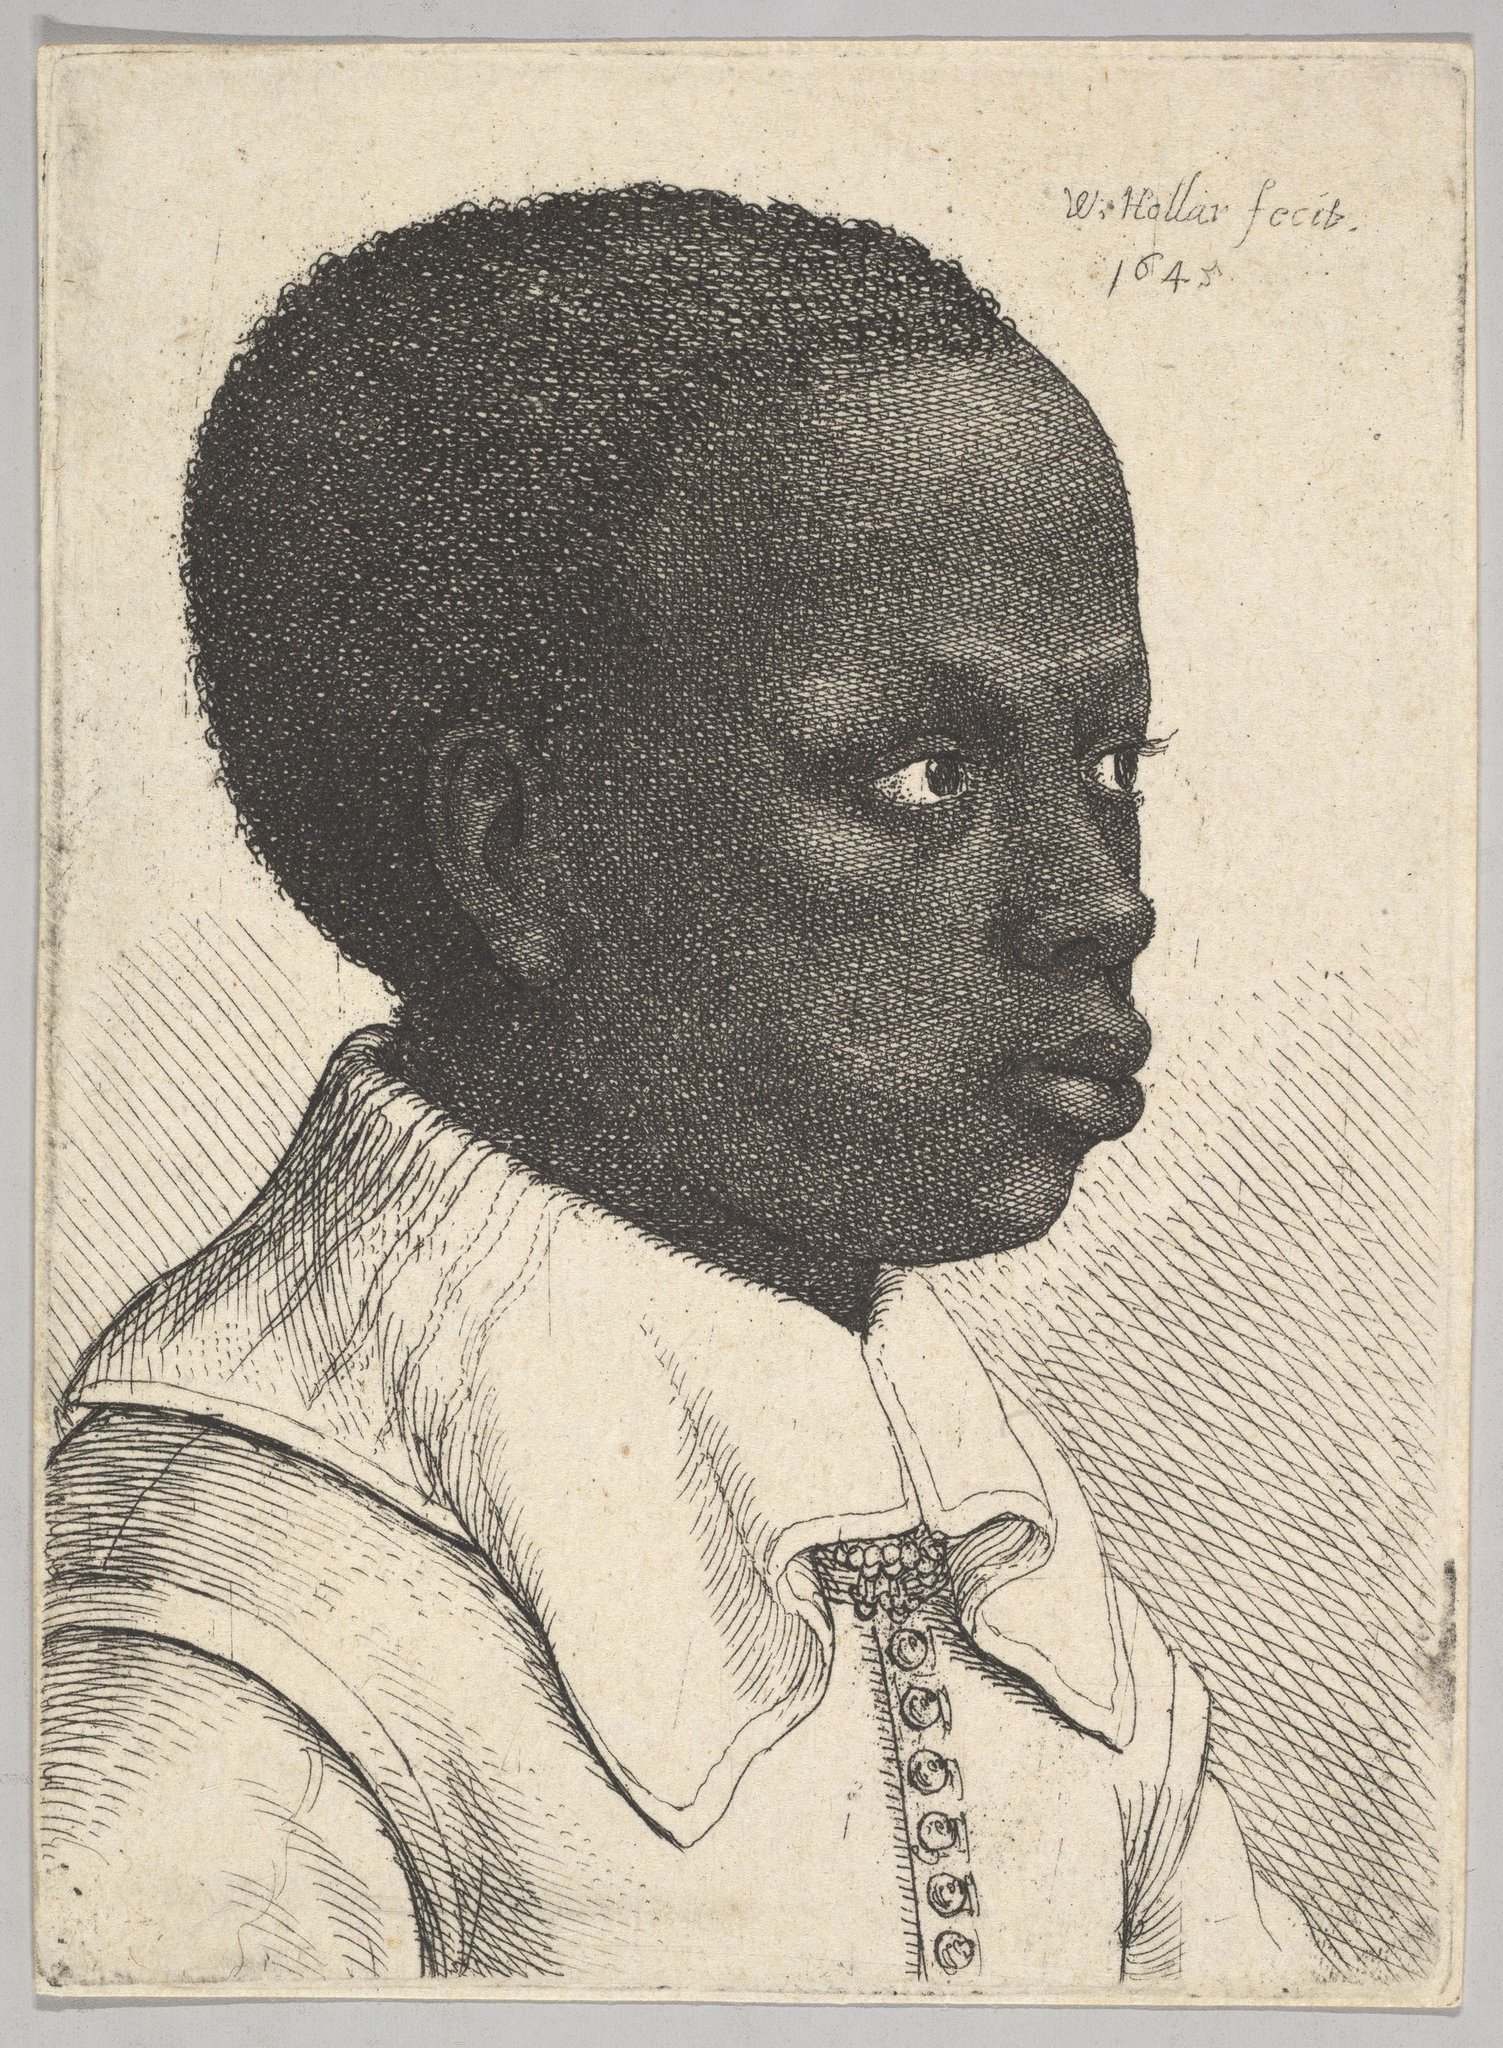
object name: print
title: Head of a Young Black Boy in Profile to the Right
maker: wenceslaus hollar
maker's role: artist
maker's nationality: bohemian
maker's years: 1607-1677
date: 1645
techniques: etching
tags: boys